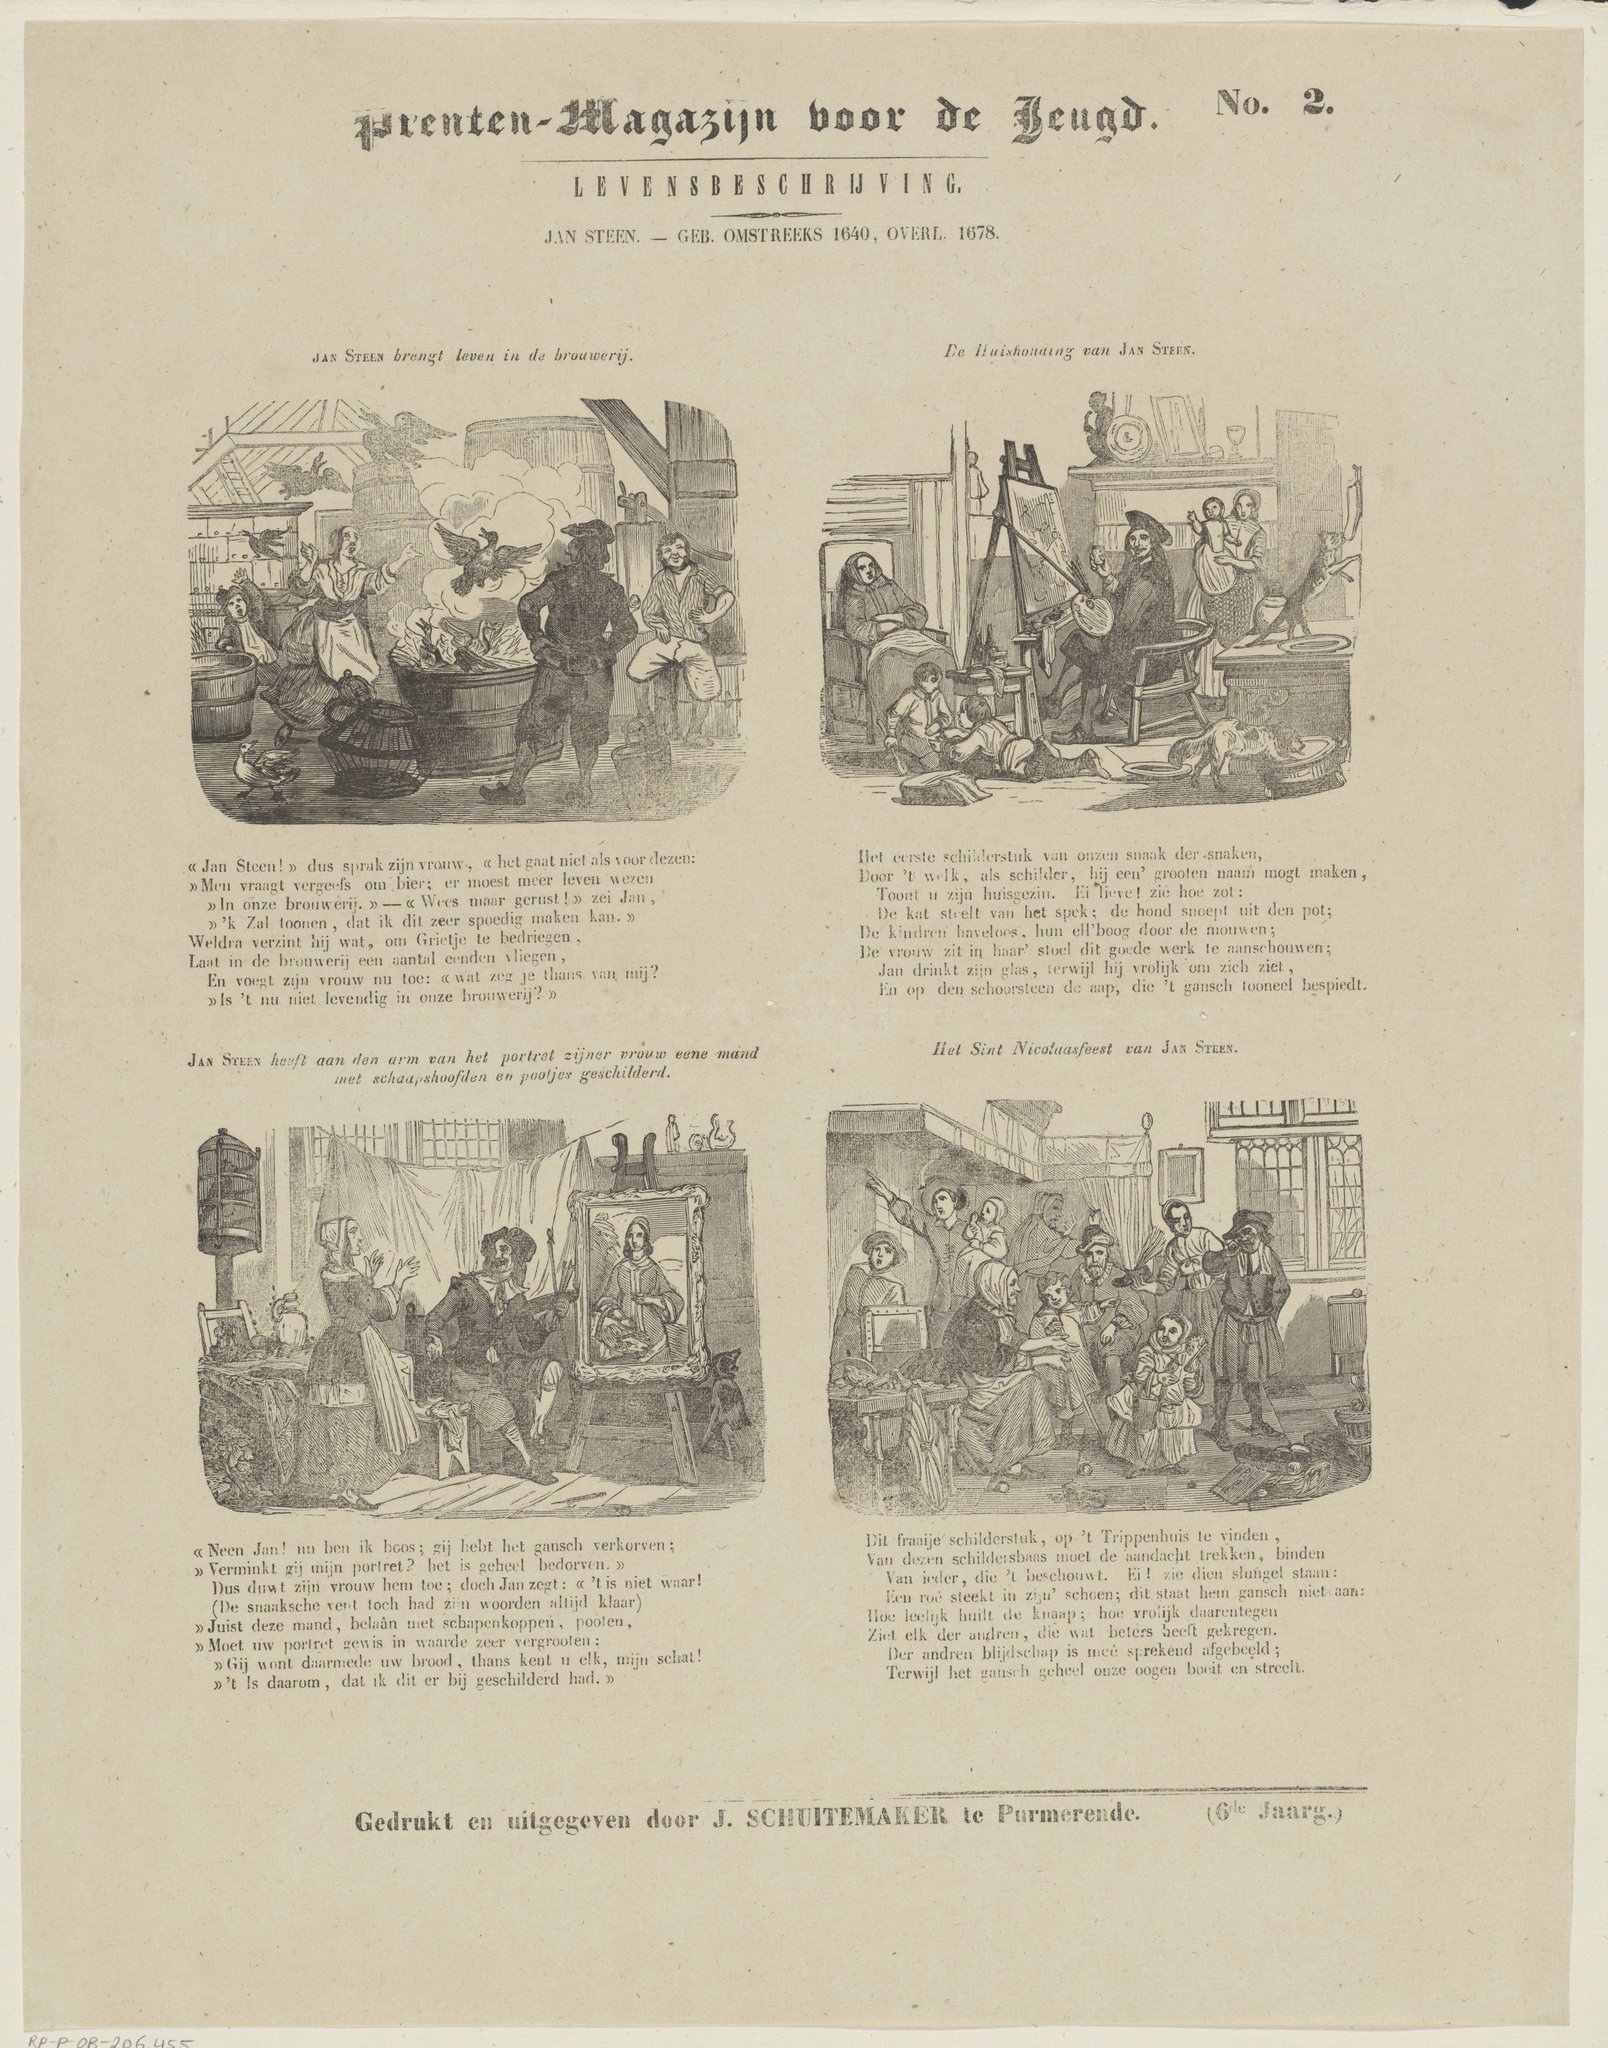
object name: popular print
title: Jan Steen. - Geb. omstreeks 1640, Overl. 1678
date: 1847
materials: paper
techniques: letterpress printing, engraving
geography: purmerend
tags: leiden, painter, print maker, jan havicksz. steen, a perfect shambles (dutch: 'huishouden van jan steen'), historical persons, workshop, studio ~ painter, painter at work, in his studio, festivities on st. nicholas (eve) (december 5), picture, painting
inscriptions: collector's mark: Lugt 2760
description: Blad met 4 voorstellingen uit het leven van Jan Havicksz. Steen. Boven elke afbeelding een titel, onder elke afbeelding een achtregelig vers. Genummerd rechtsboven: No. 2.